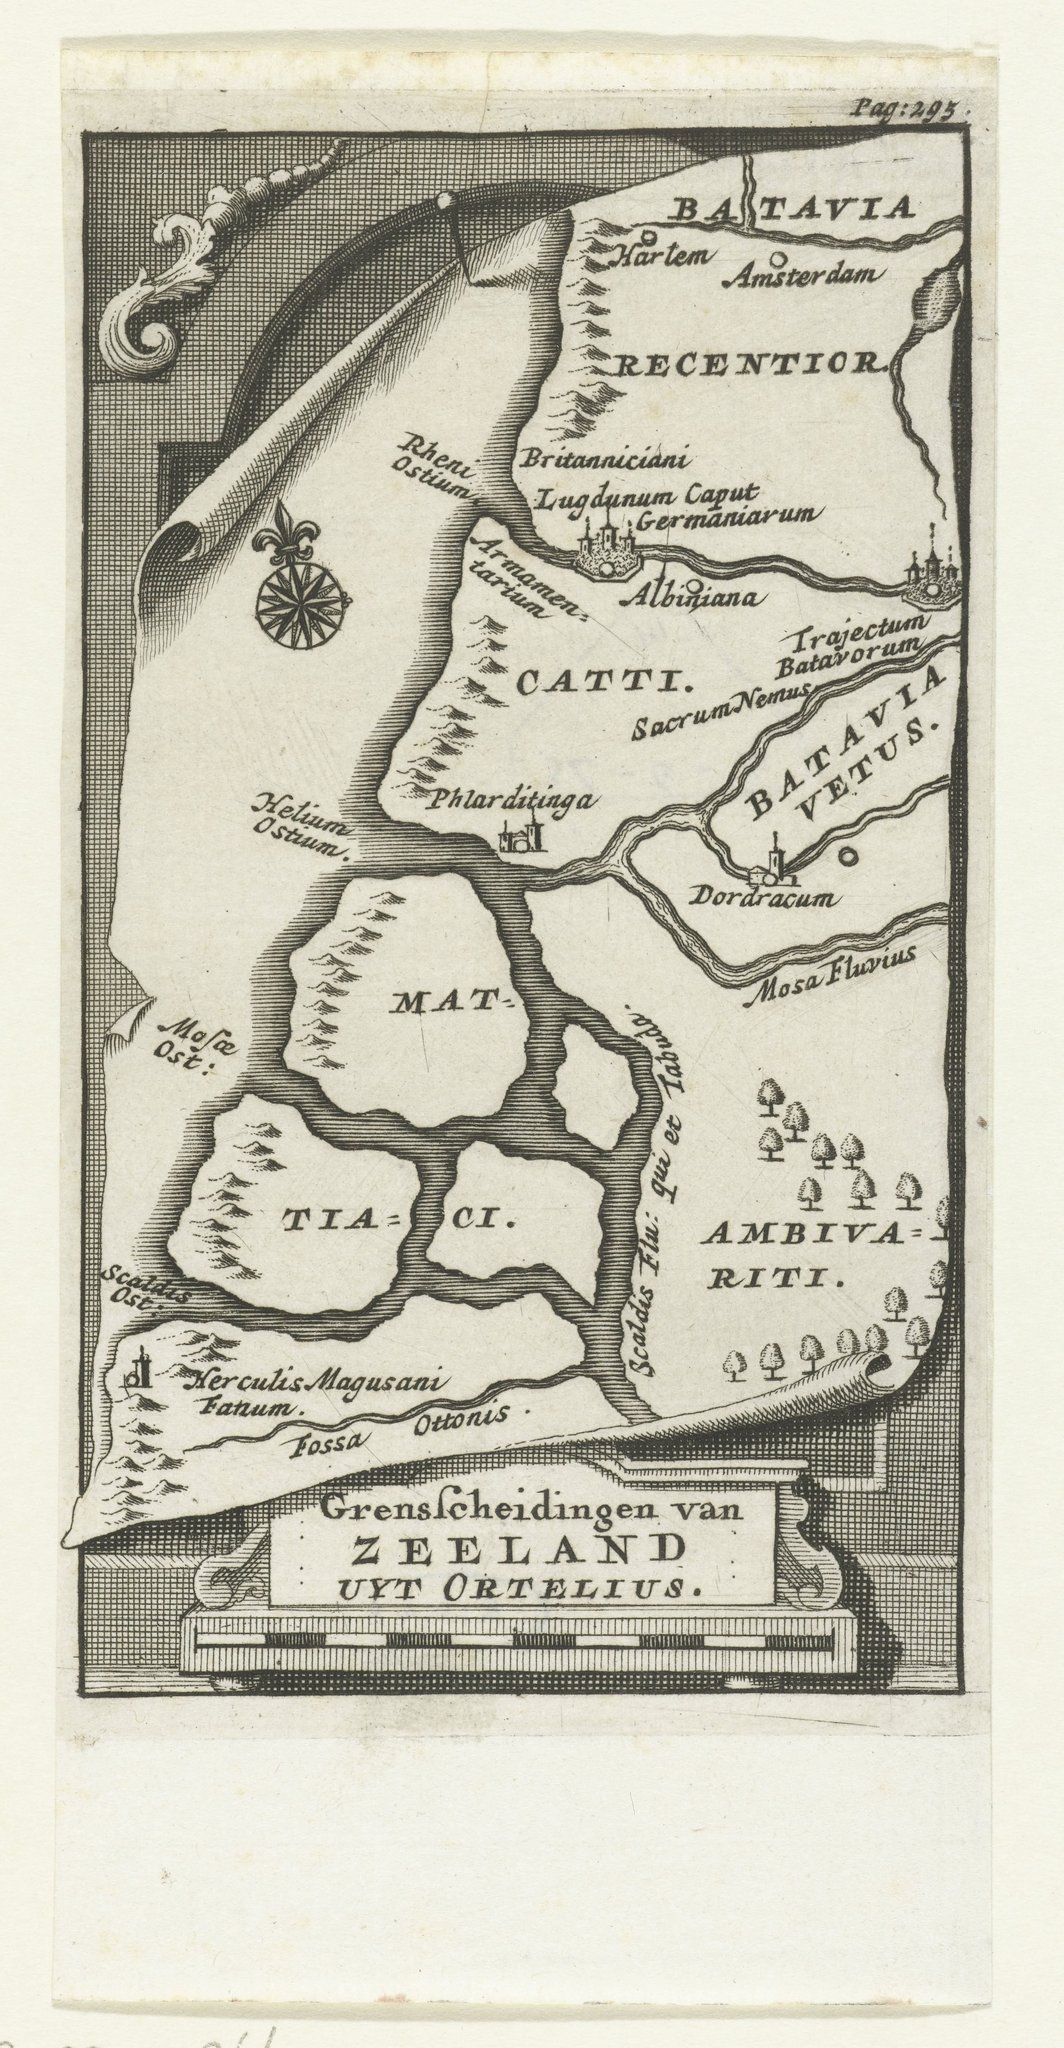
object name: history print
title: Kaartje van de Zeeuwse eilanden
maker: Anonymous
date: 1713-1717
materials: paper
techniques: etching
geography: netherlands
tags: maps of separate countries or regions, zeeland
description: Illustratie voor: Mattheus Gargon, Walchersche arkadia, Samuel (I) Luchtmans, Leiden 1715-1717, pag. 295.